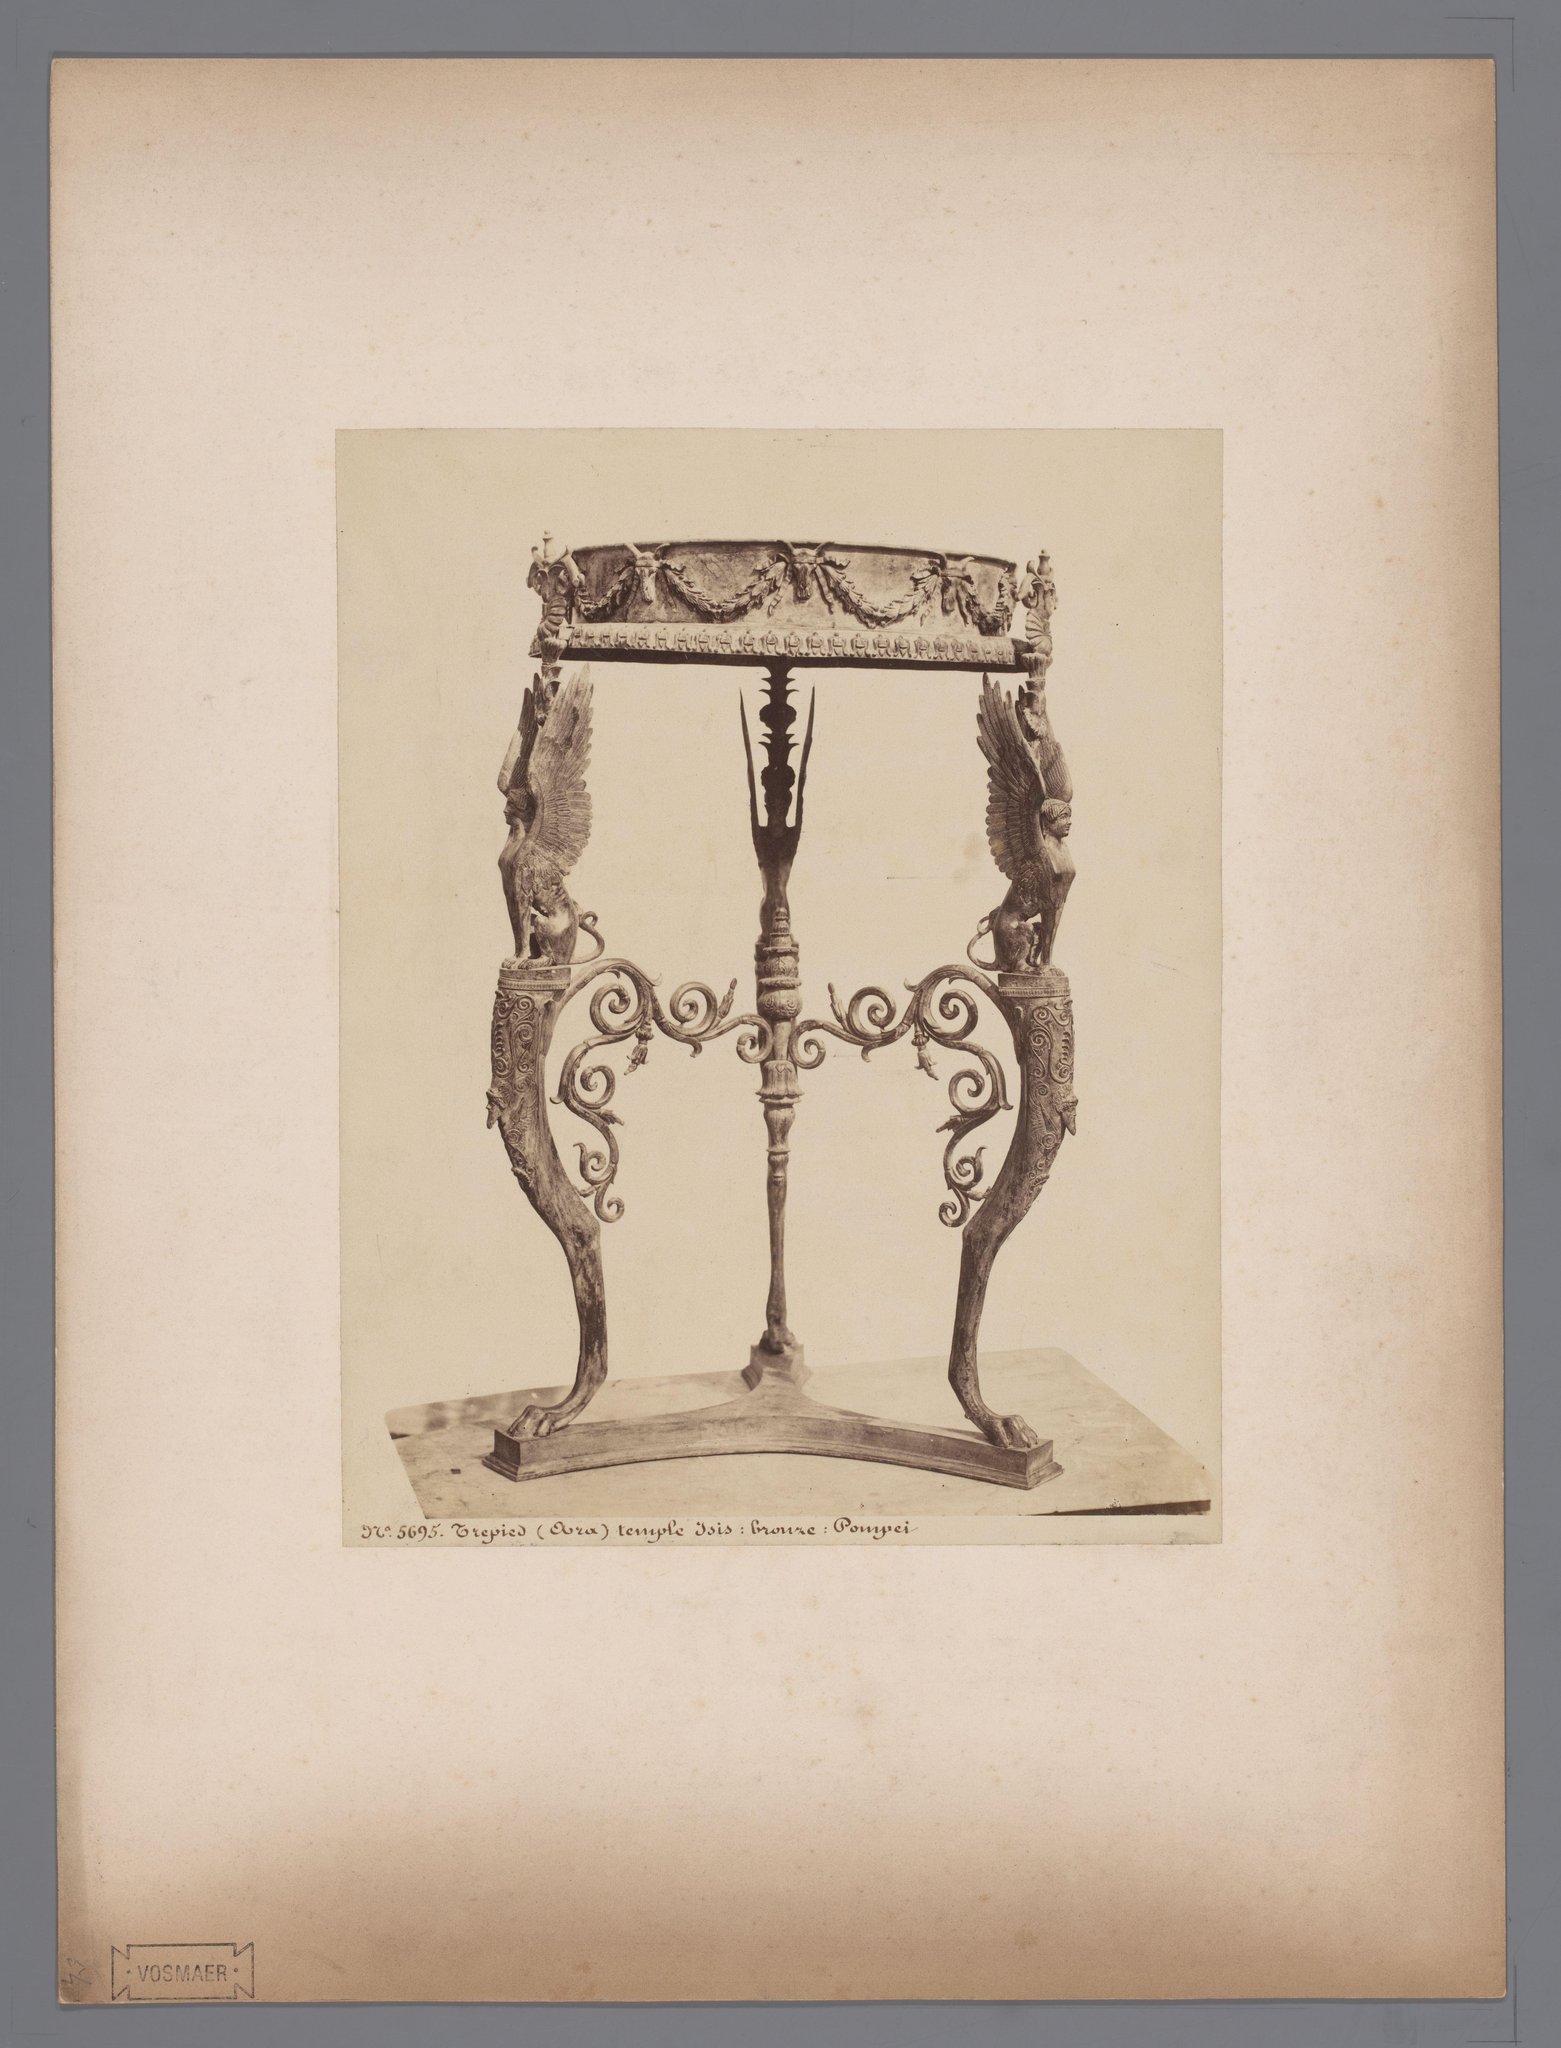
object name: photograph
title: Trepied (Oura) temple d'Isis: bronze: Pompei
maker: giorgio sommer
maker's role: fotograaf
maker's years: 1834-1914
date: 1857-1914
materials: cardboard, paper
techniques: albumen print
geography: pompeii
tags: furniture and household effects, temple, shrine ~ non-christian religions, pompeii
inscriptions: number: ‘54’, number: ‘No. 5695’